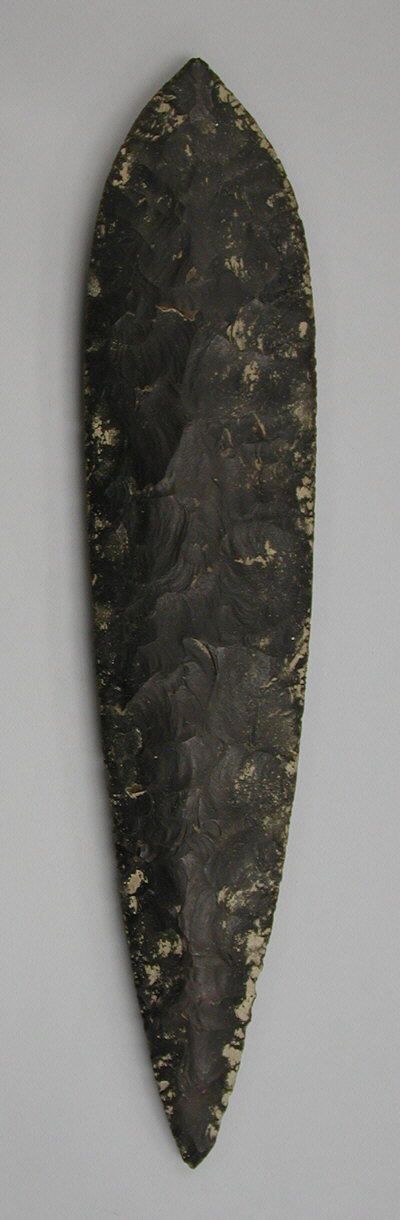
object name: knife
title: Flint Blade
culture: mexican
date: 1501-1600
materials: stone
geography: mexico